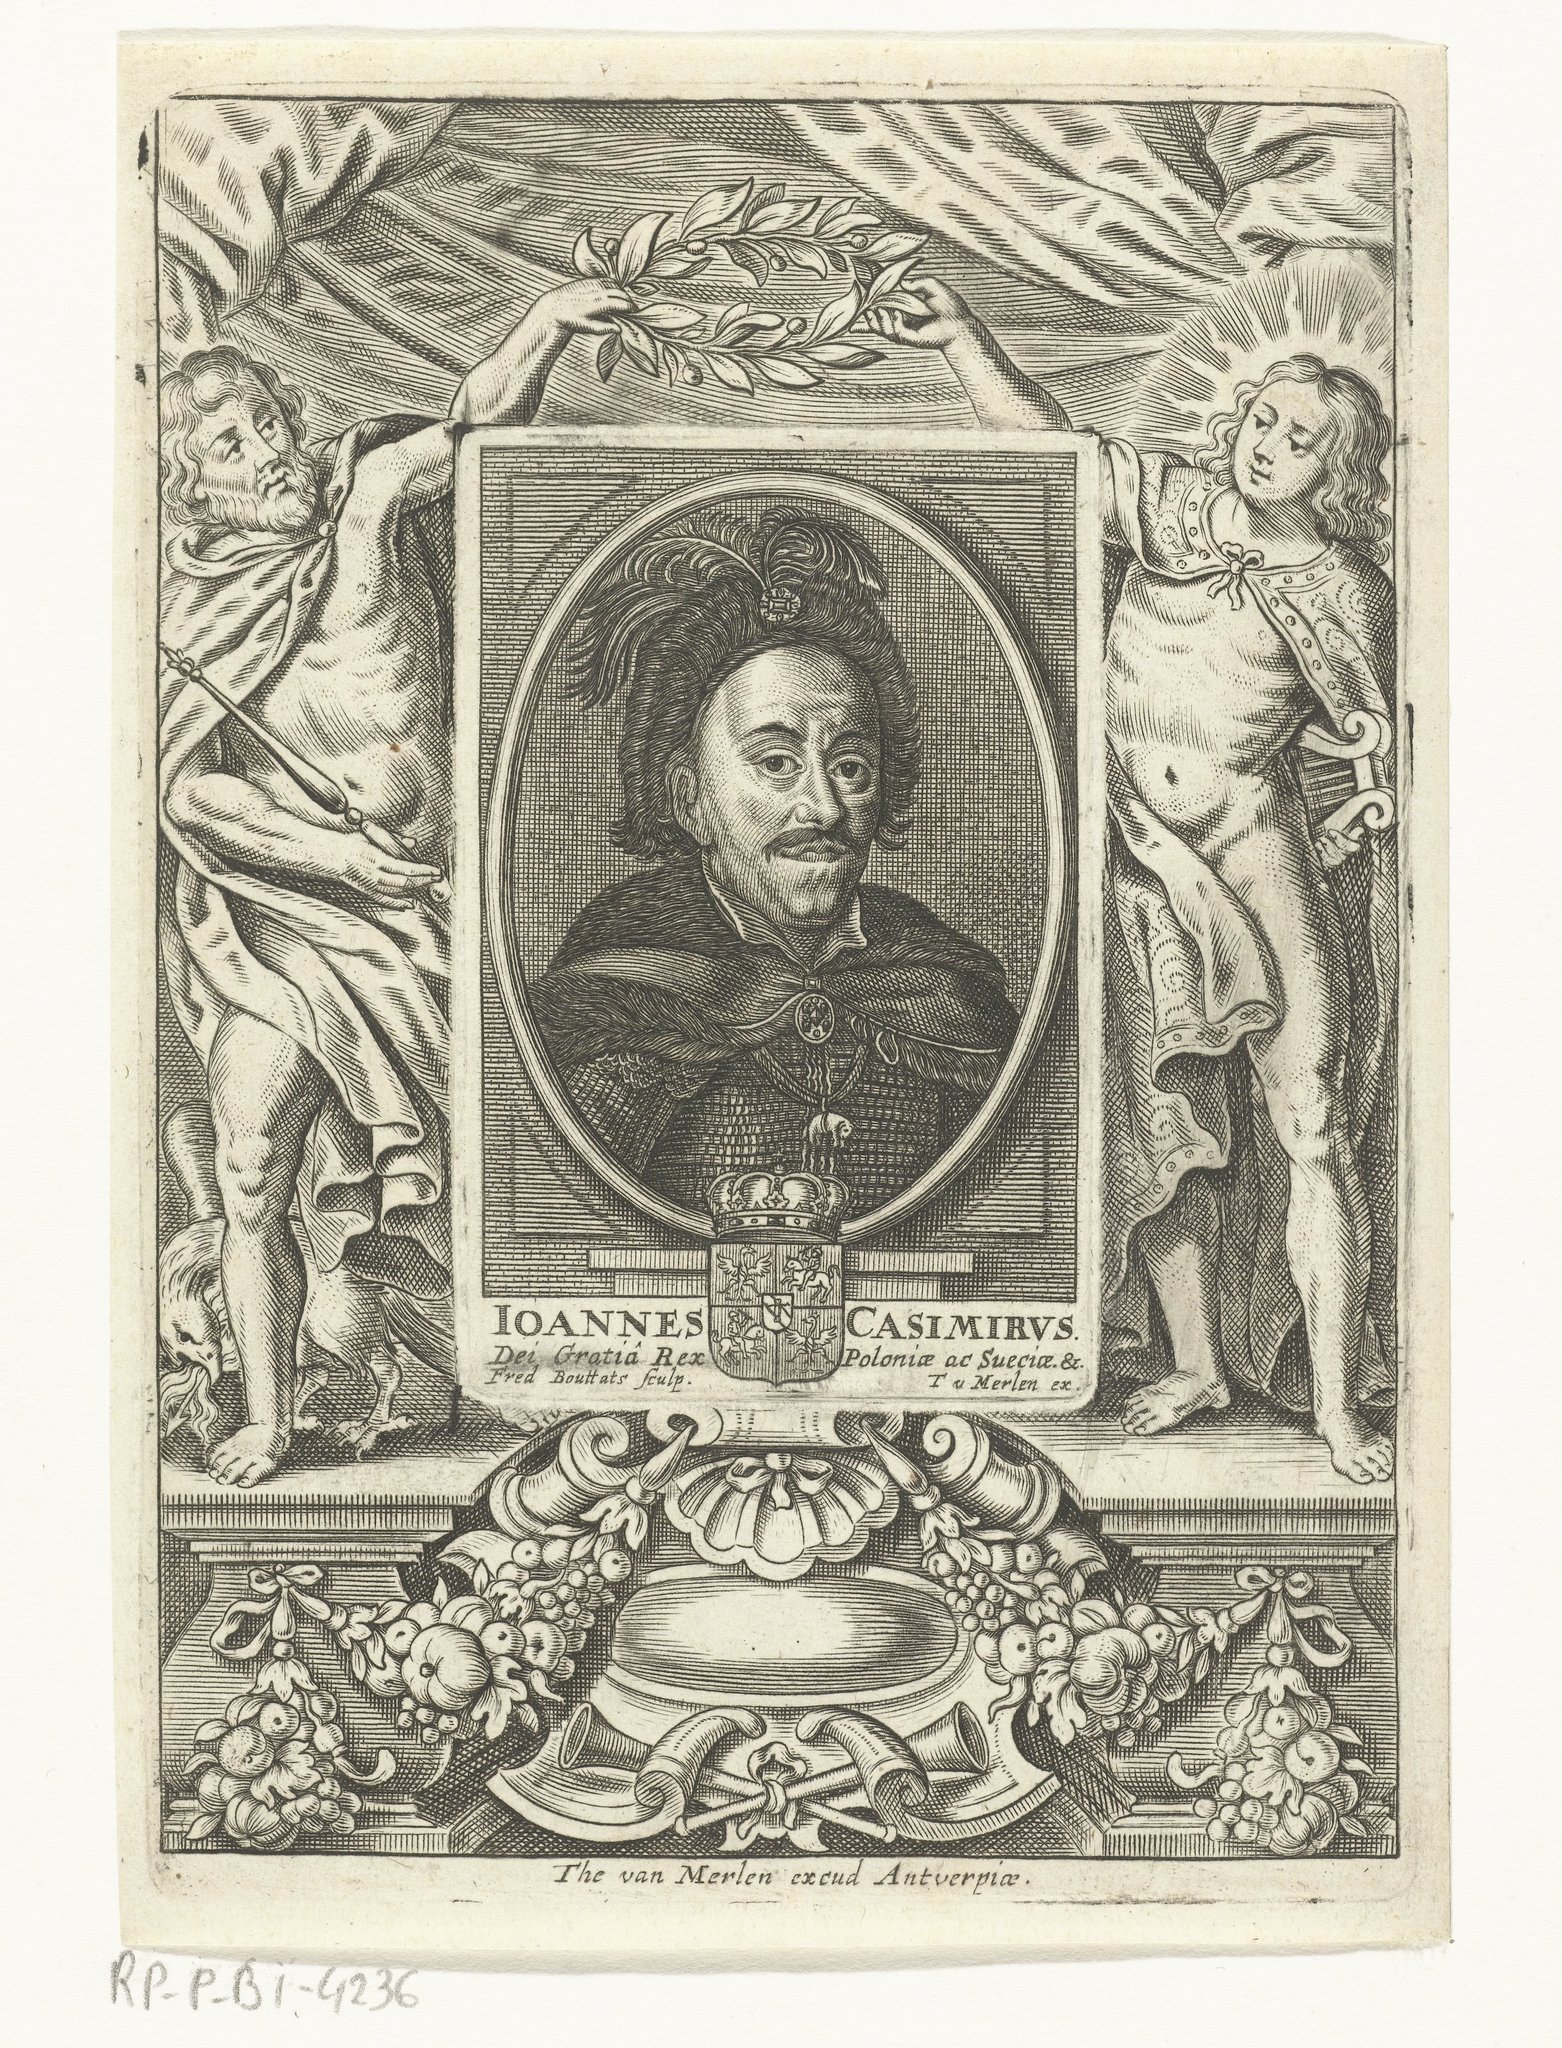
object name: print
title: Portret van Jan II Kazimierz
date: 1648-1676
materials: paper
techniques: engraving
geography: antwerp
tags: (story of) apollo (phoebus), (story of) jupiter (zeus)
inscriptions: collector's mark: Lugt 2228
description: Portret in een ovale lijst van Jan II Kazimierz, koning van Polen. Buste naar rechts. Het portret staat in een rechthoekig kader tussen twee klassieke goden, Jupiter en Apollo. Ze houden een lauwerkrans boven het portret.. De prent heeft een Latijns onderschrift met de naam van de geportretteerde.